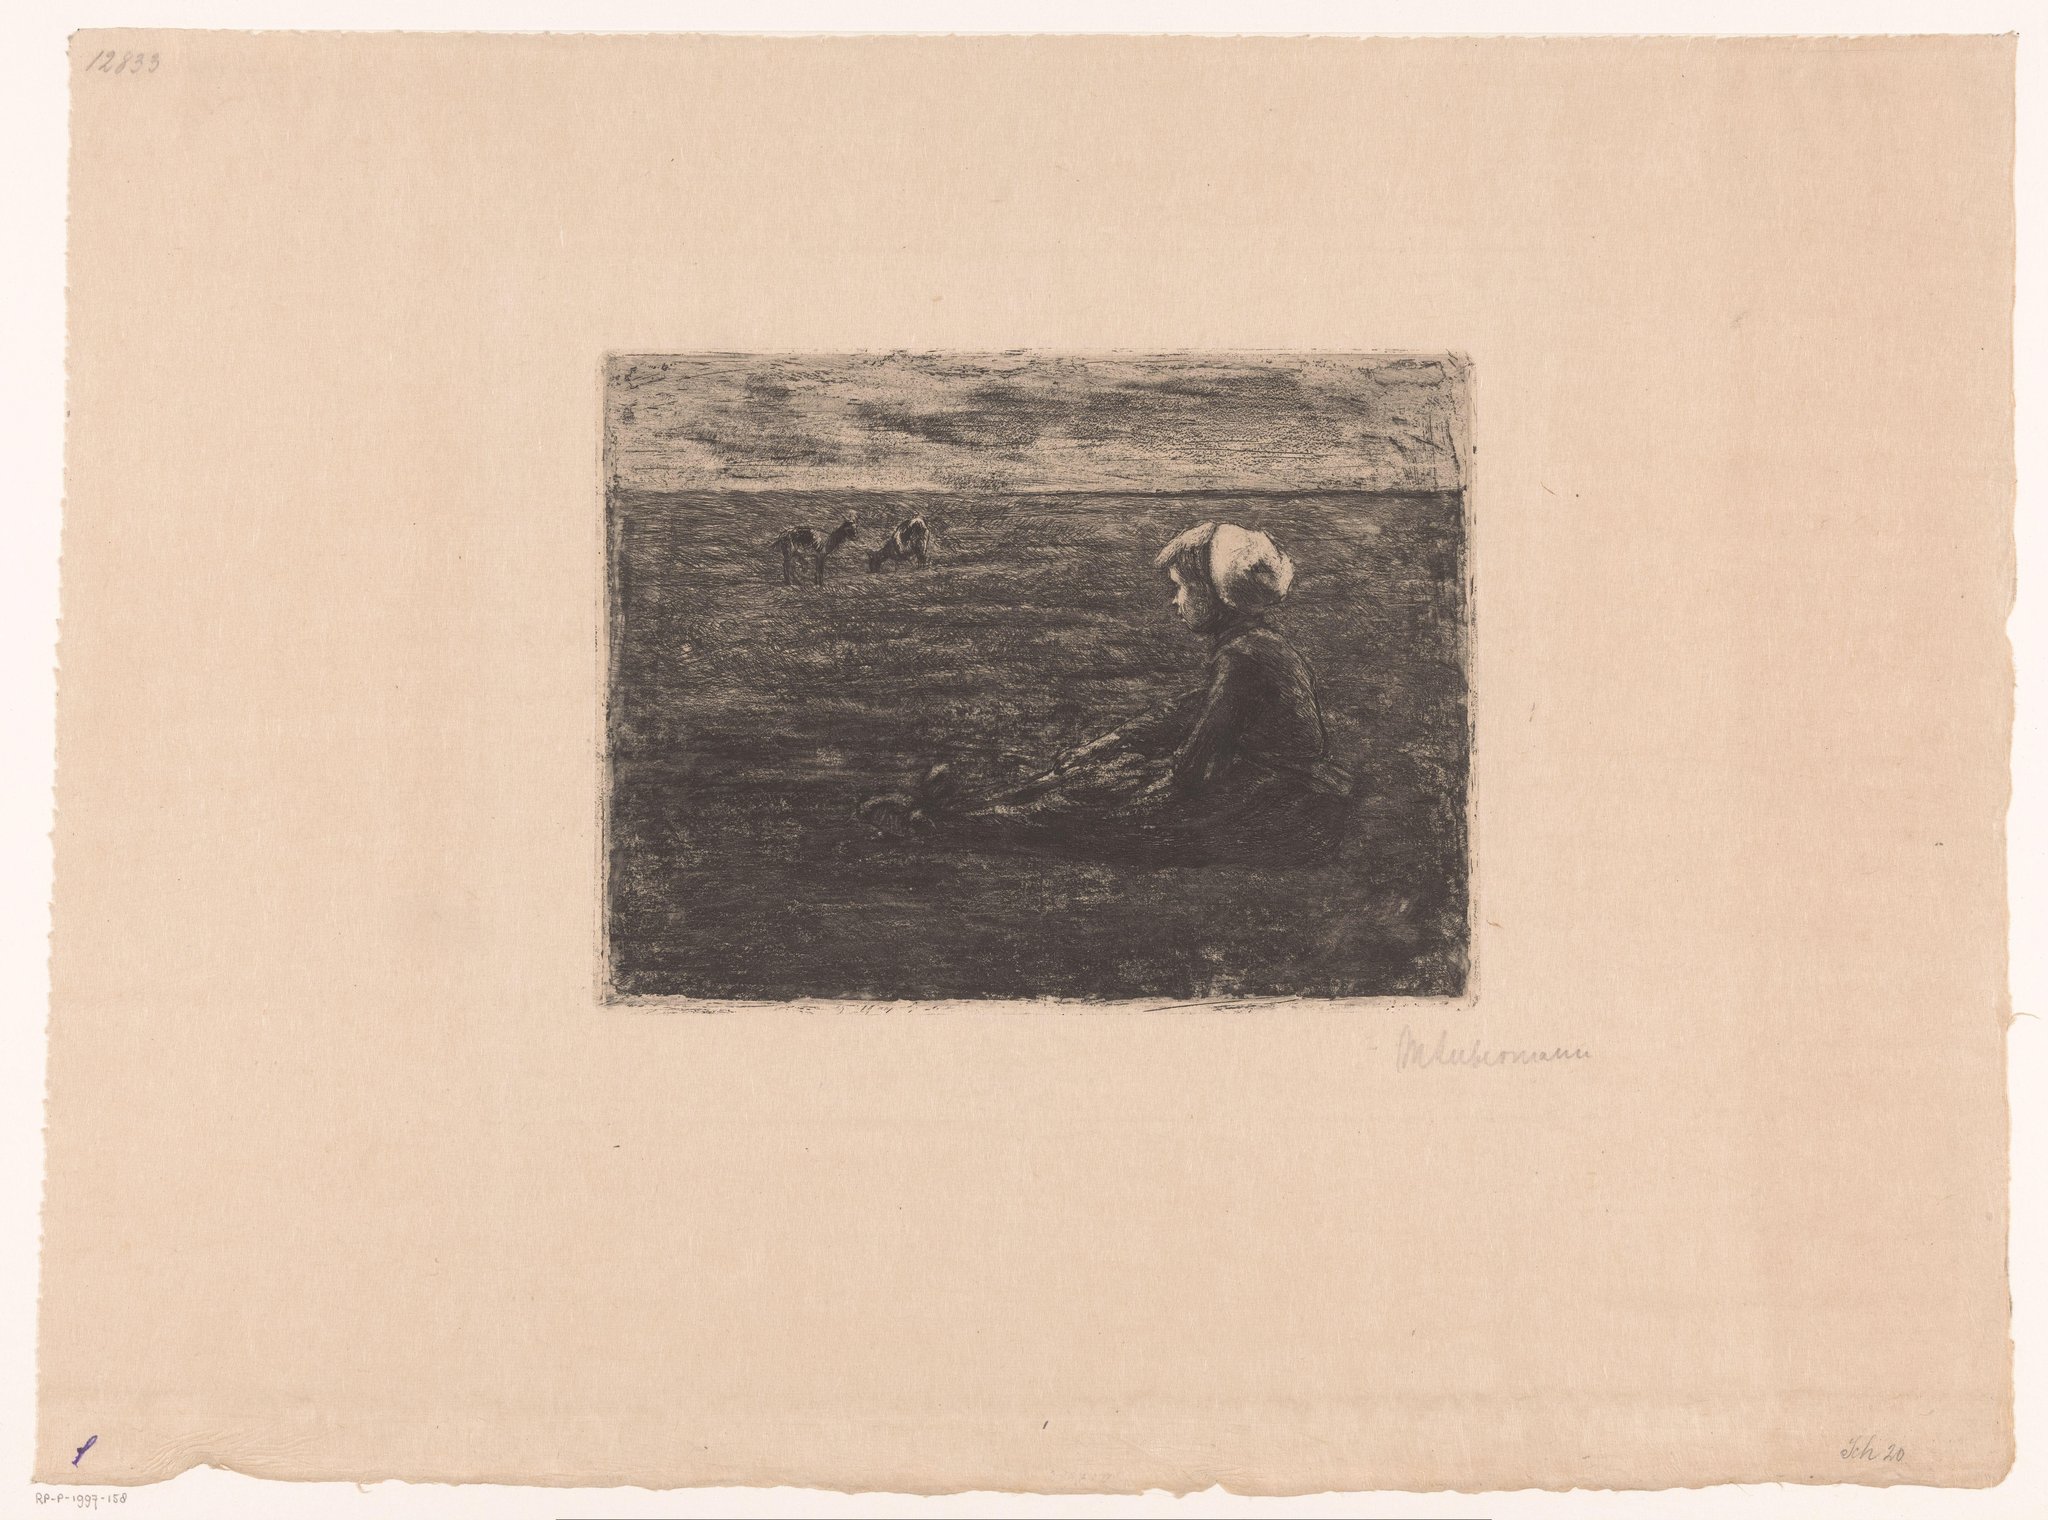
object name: print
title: Jonge geitenhoedster zittend in het veld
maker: max liebermann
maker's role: draughtsman, print maker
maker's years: 1847-1935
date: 1857-1935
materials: paper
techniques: drypoint, soft ground etching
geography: berlin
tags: adolescent, young woman, maiden, herding, herdsman, herdswoman, shepherd, shepherdess, cowherd, etc., goat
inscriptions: inscription: ‘12833’, inscription: ‘Ziegenhirtin’, collector's mark: Lugt 2228, signature:, inscription: ‘#13764’